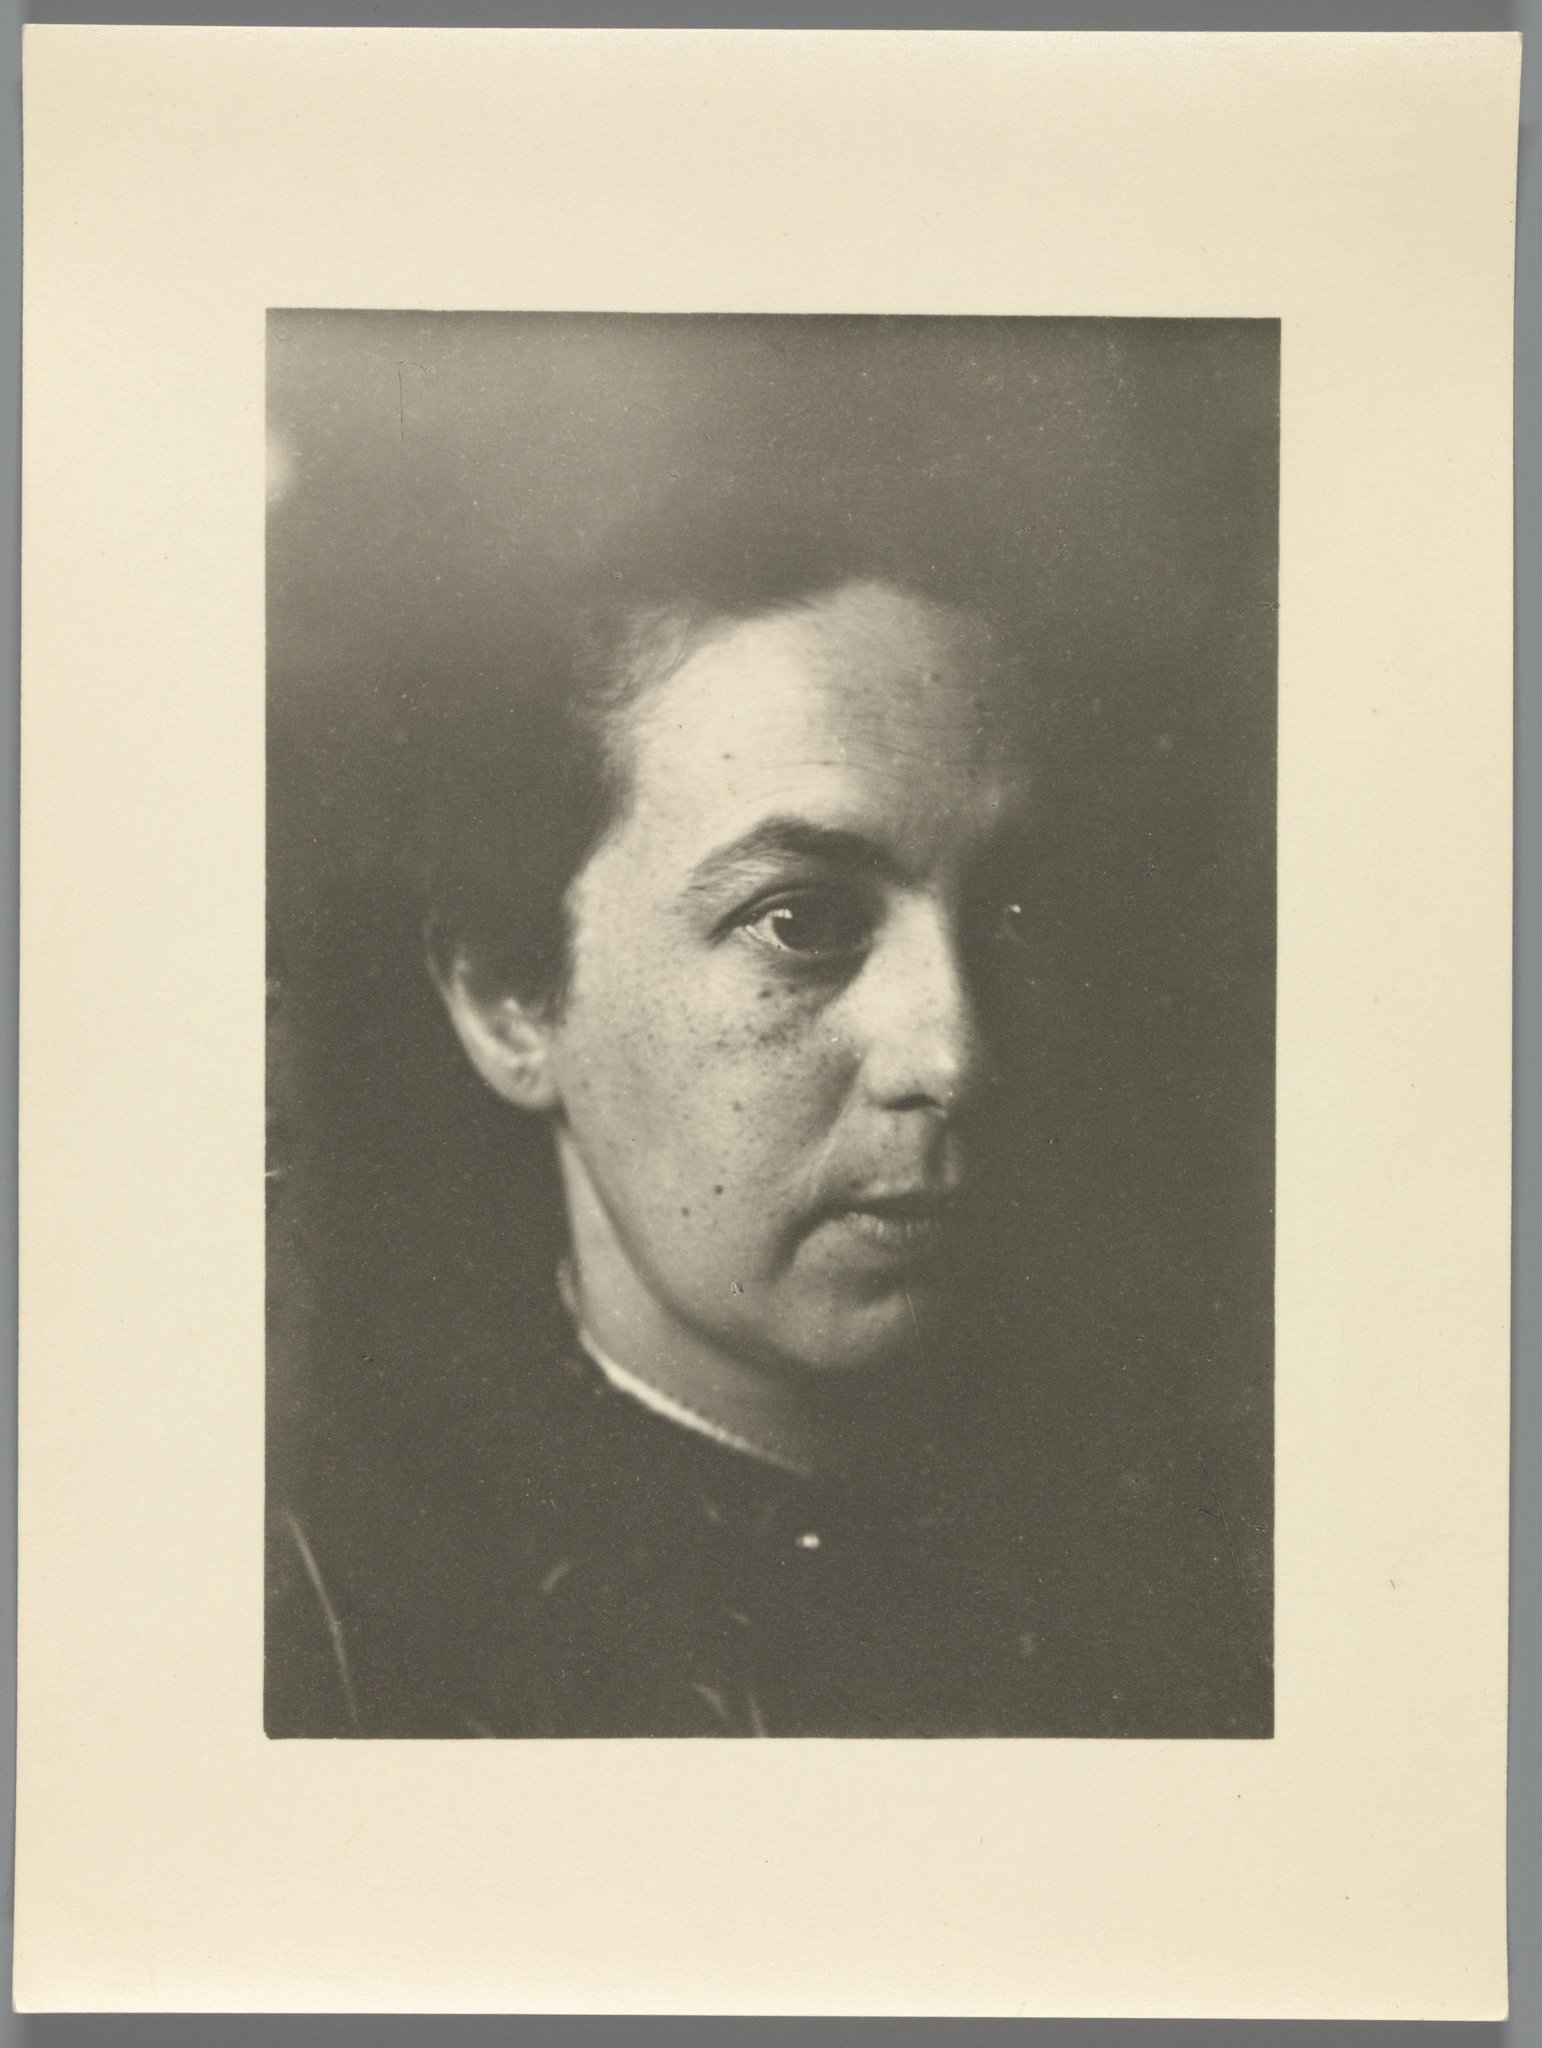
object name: photograph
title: Reproductie naar een foto van Willem Witsen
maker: Anonymous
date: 1860-1915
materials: paper, photographic support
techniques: gelatin silver print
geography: netherlands